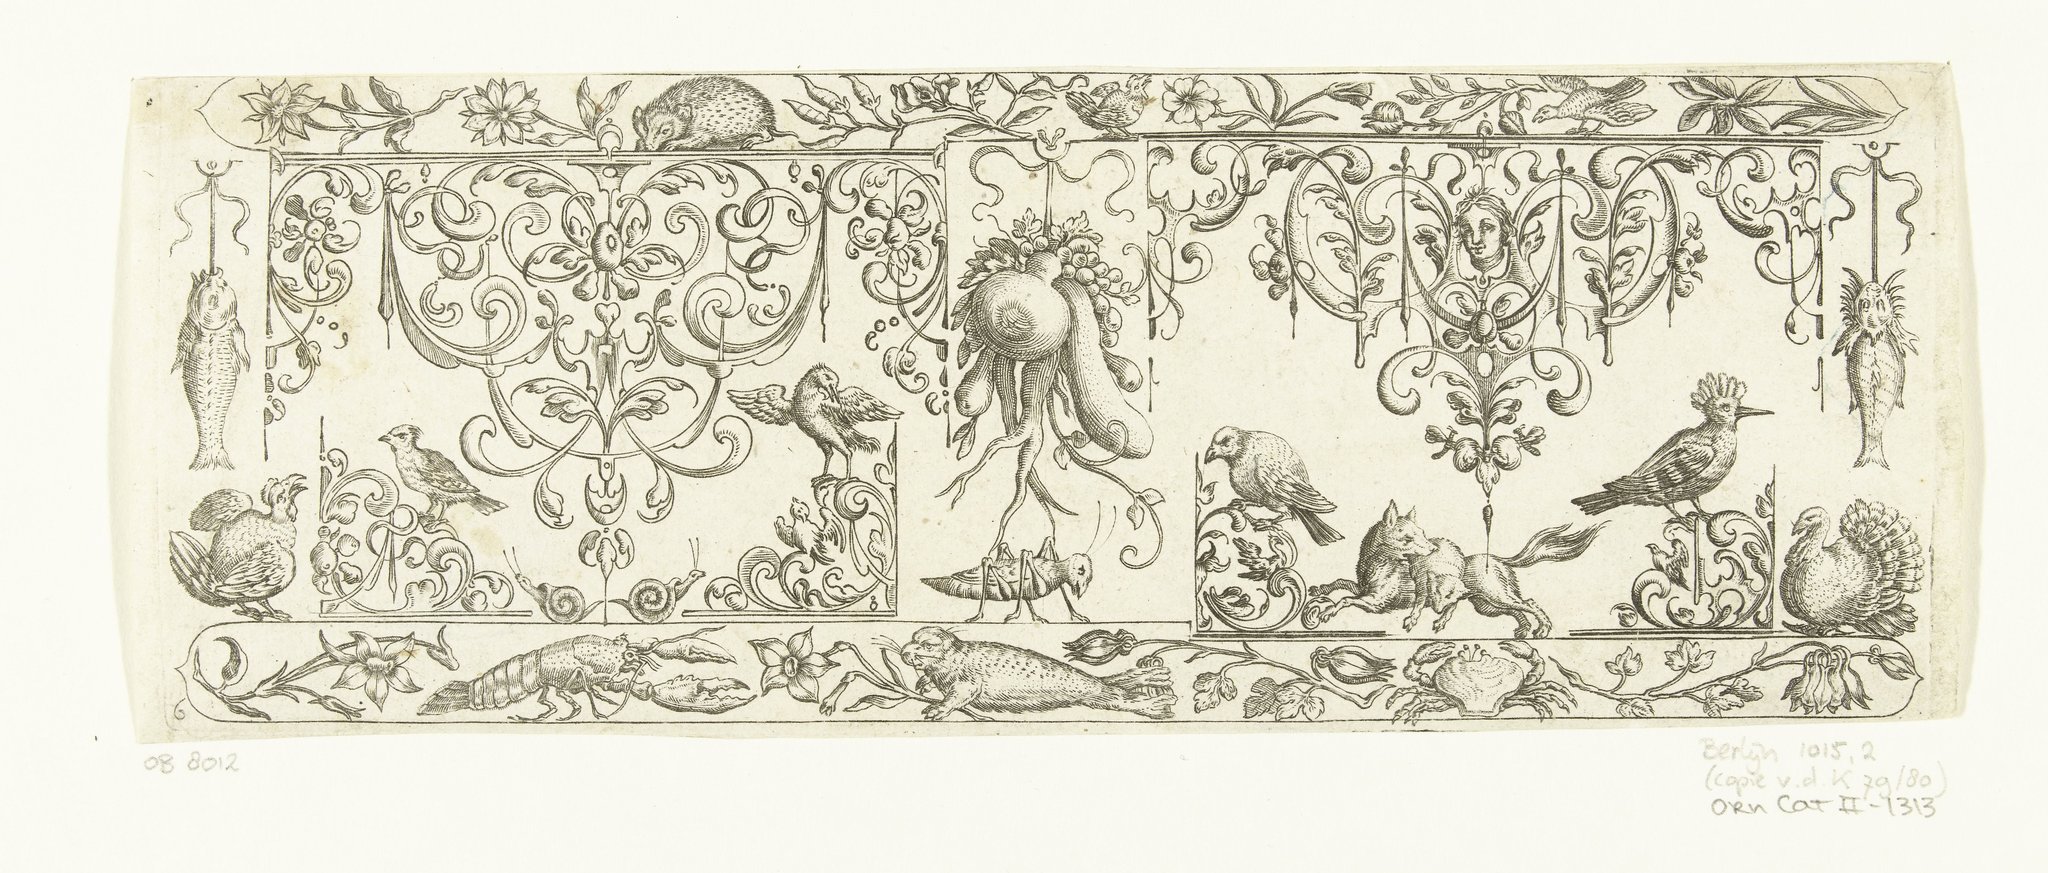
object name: ornament print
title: Spitsen en randen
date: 1611-1656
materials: paper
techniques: engraving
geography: france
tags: crustaceans: crayfish, fantasy ornament, crustaceans: crab, swimming mammals: seal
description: Tegenzijdige kopie naar prenten (blad 8 en 9) uit de serie Somige Eenvoldige Vruchten en Spitsen. Uit serie bladen waarop telkens twee motieven naast elkaar te zien zijn, aangevuld met vogels, insecten, bloempotten en soms een ornamentele rand met ranken en dieren.